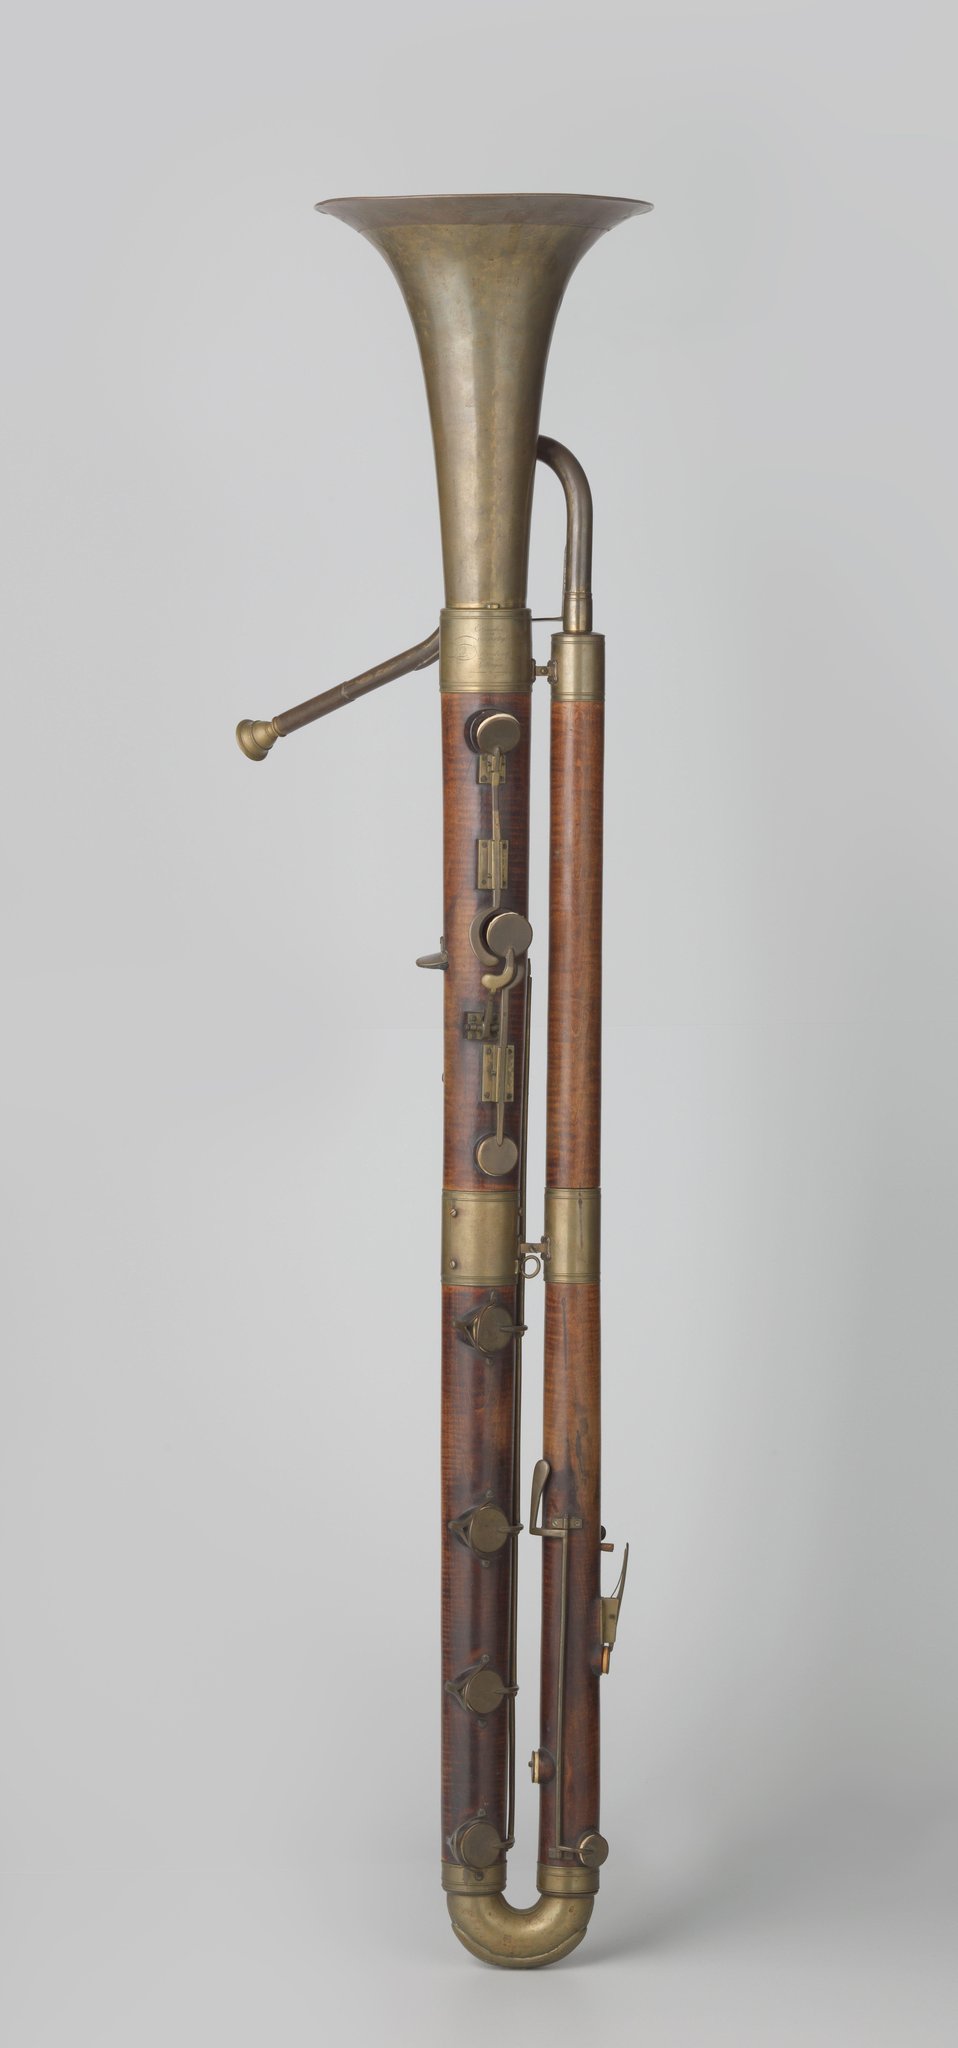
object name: horn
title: Chromatic bass horn bell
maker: johann heinrich gottlieb streitwolf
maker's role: musical instrument maker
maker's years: 1779-1837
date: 1790-1837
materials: copper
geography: gottingen